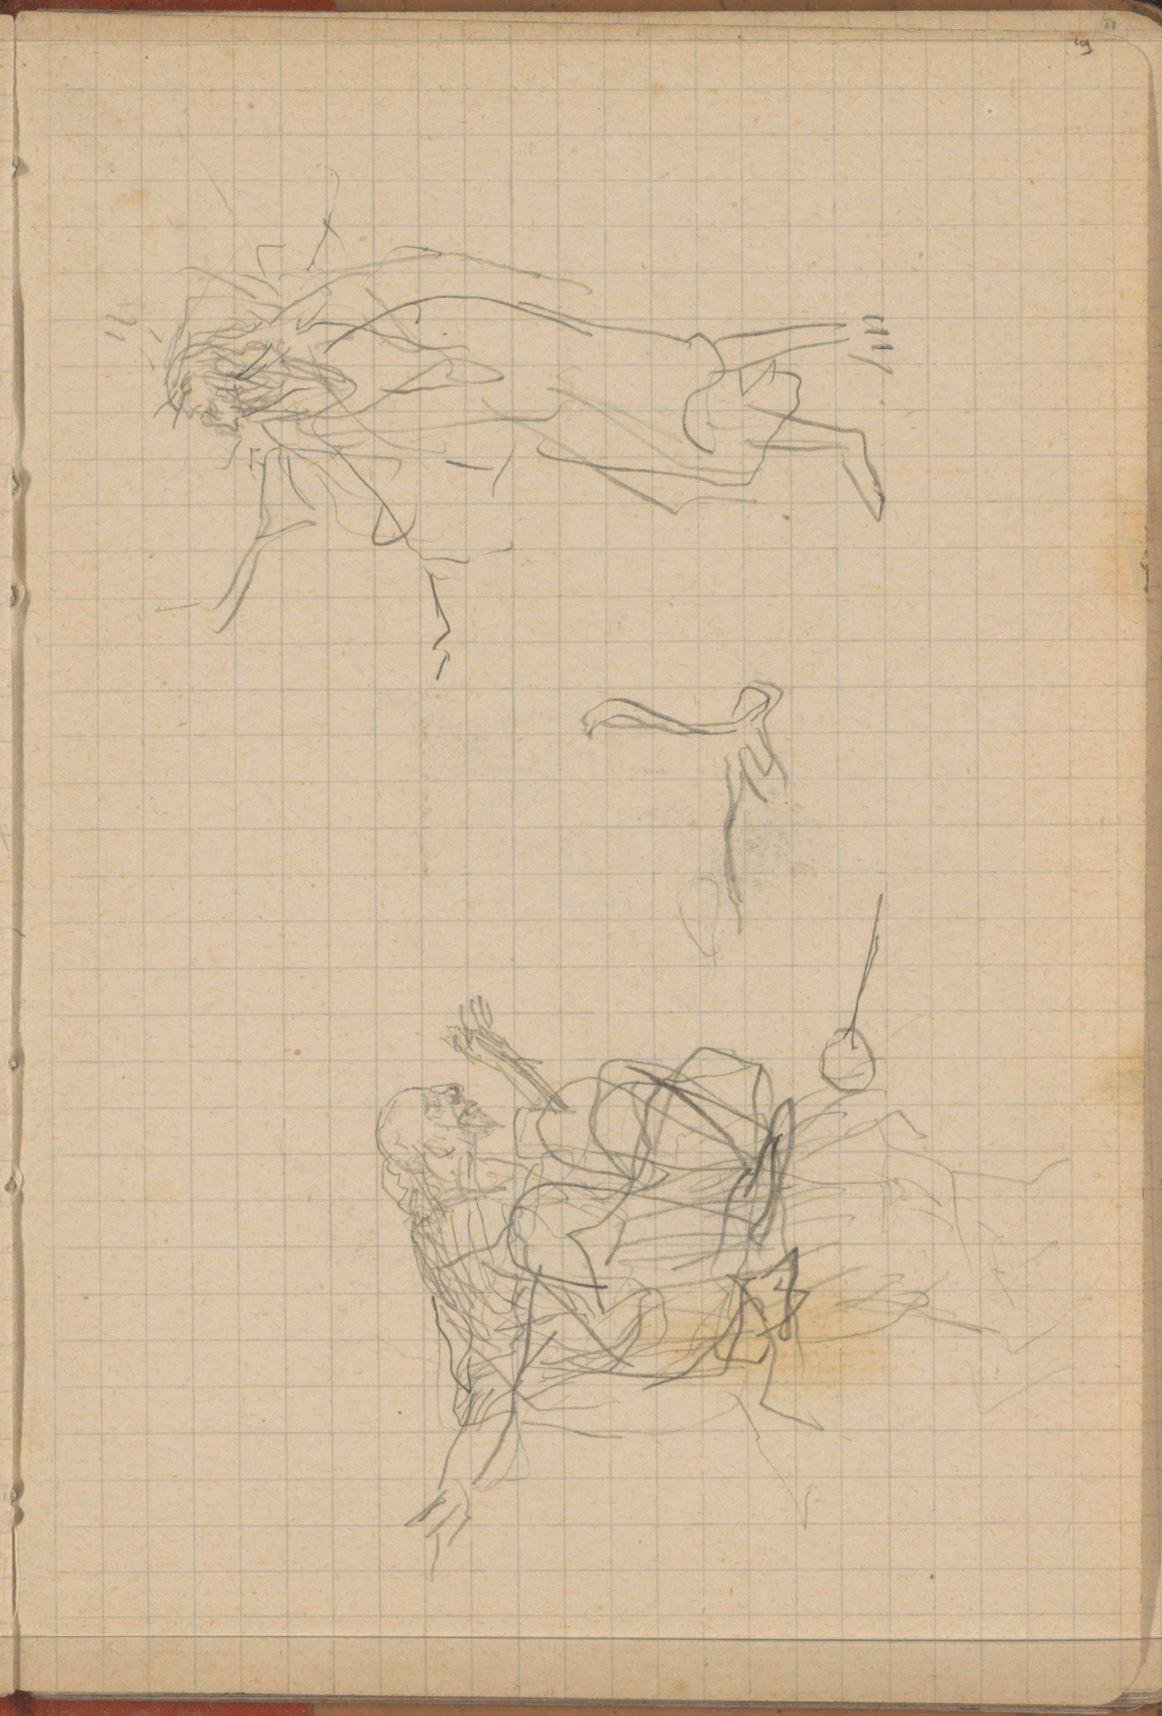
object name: sketchbook leaf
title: Slangenbezweerder met een toeschouwer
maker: marius bauer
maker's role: draughtsman, print maker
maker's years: 1867-1932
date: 1909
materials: pencil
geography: tunis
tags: performance, standing figure, snakes, squatting, crouching figure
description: Pagina 19 uit een schetsboek met 67 bladen.